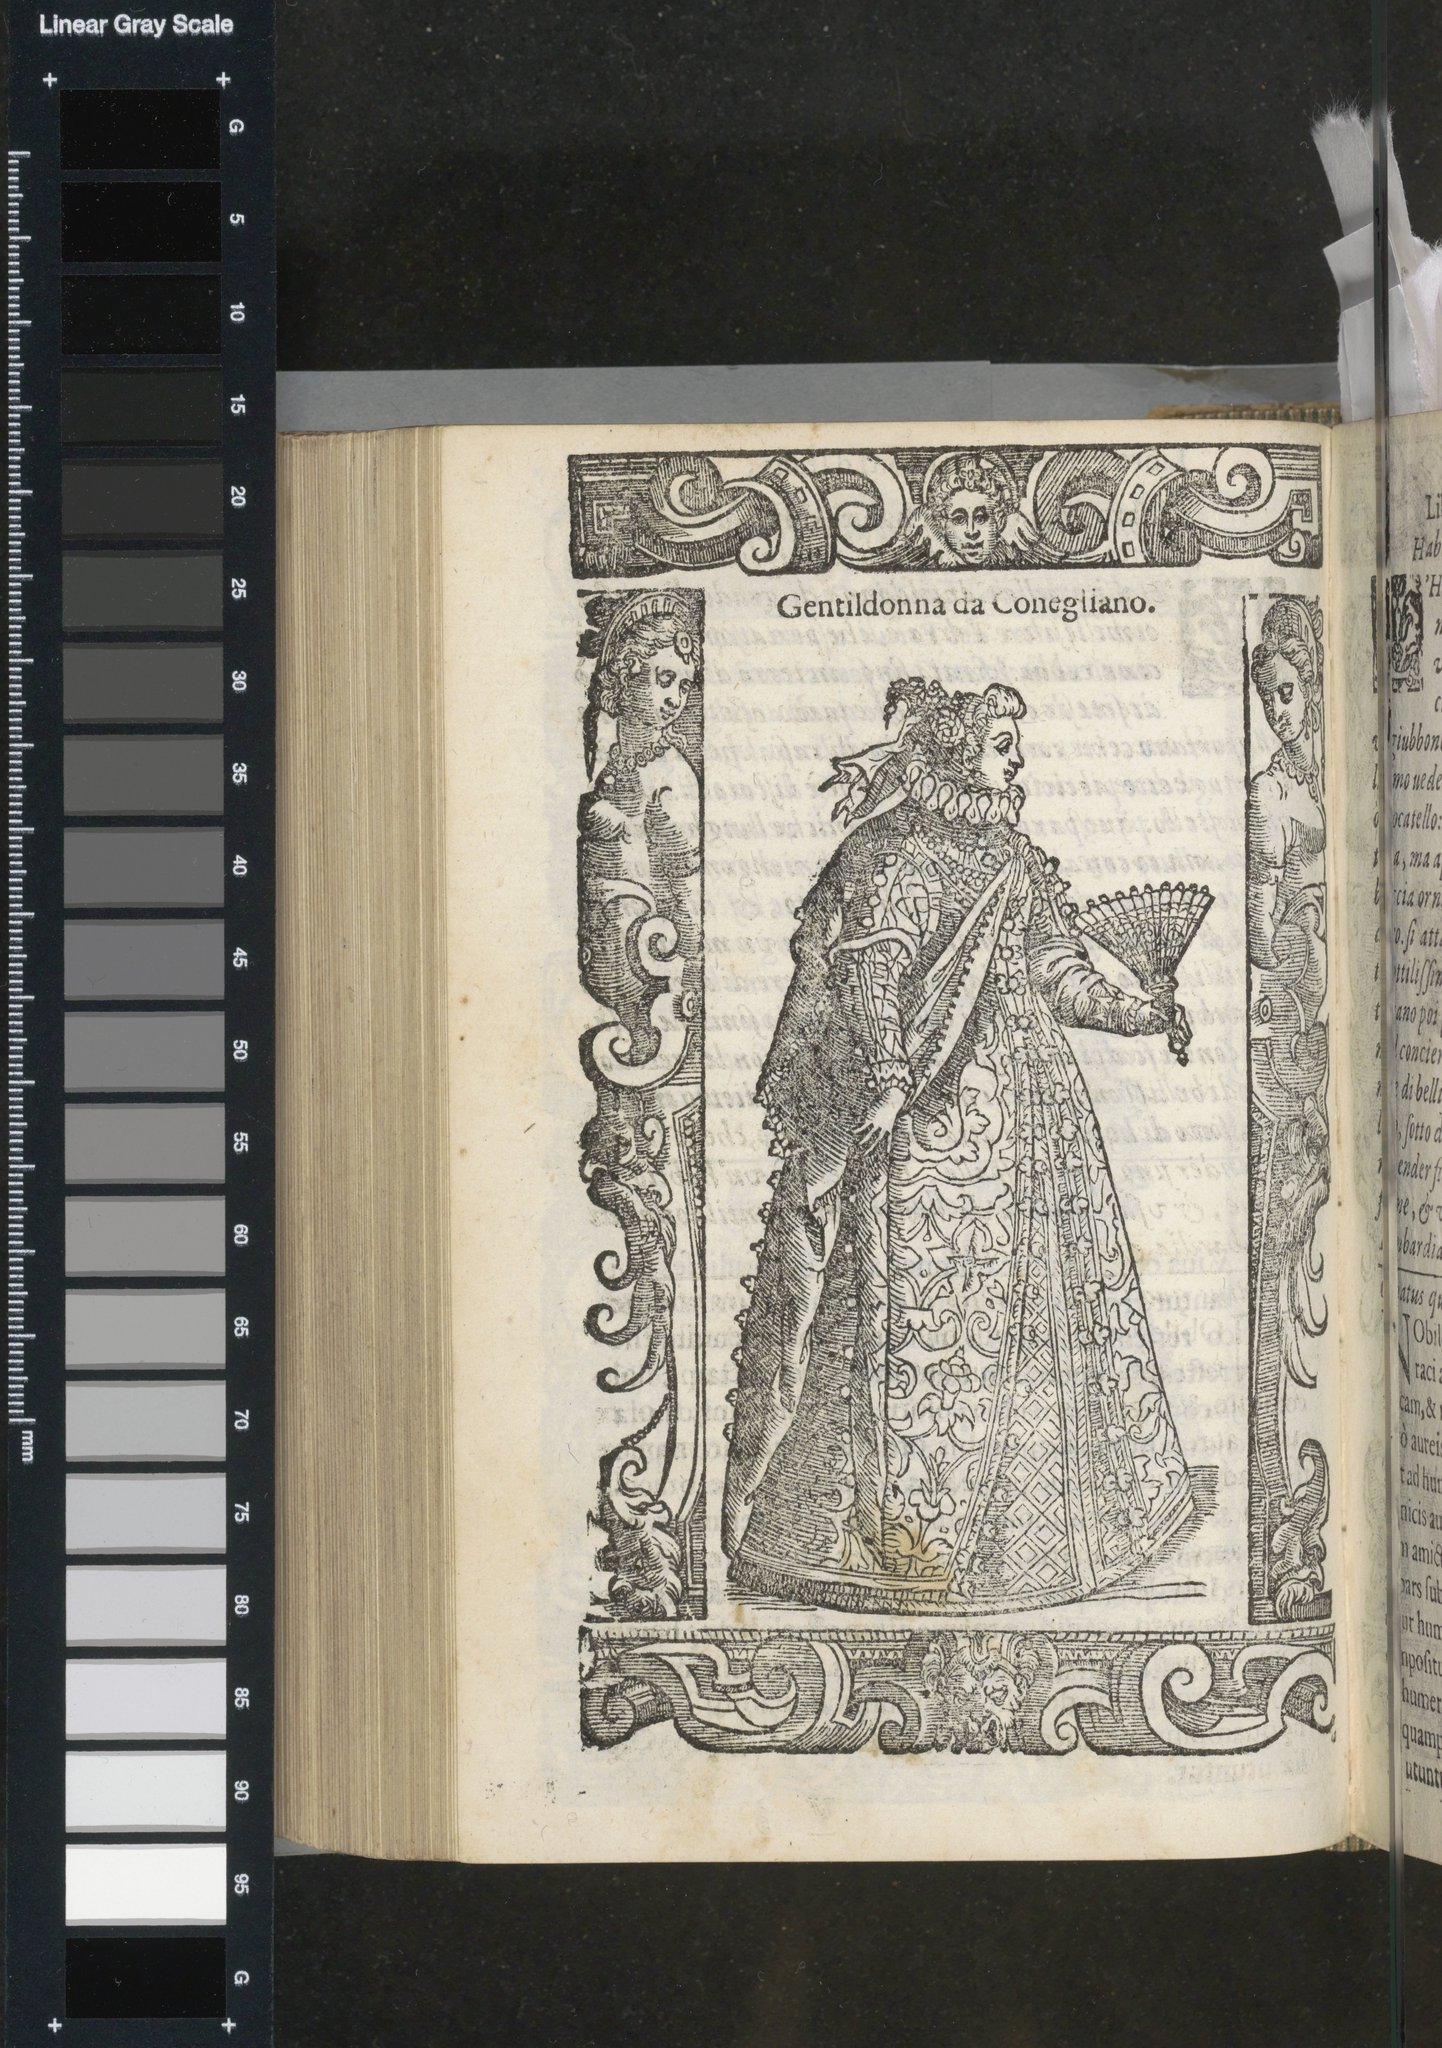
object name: costume print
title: Gentildonna da conegliano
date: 1598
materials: paper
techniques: woodcut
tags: fashion plates